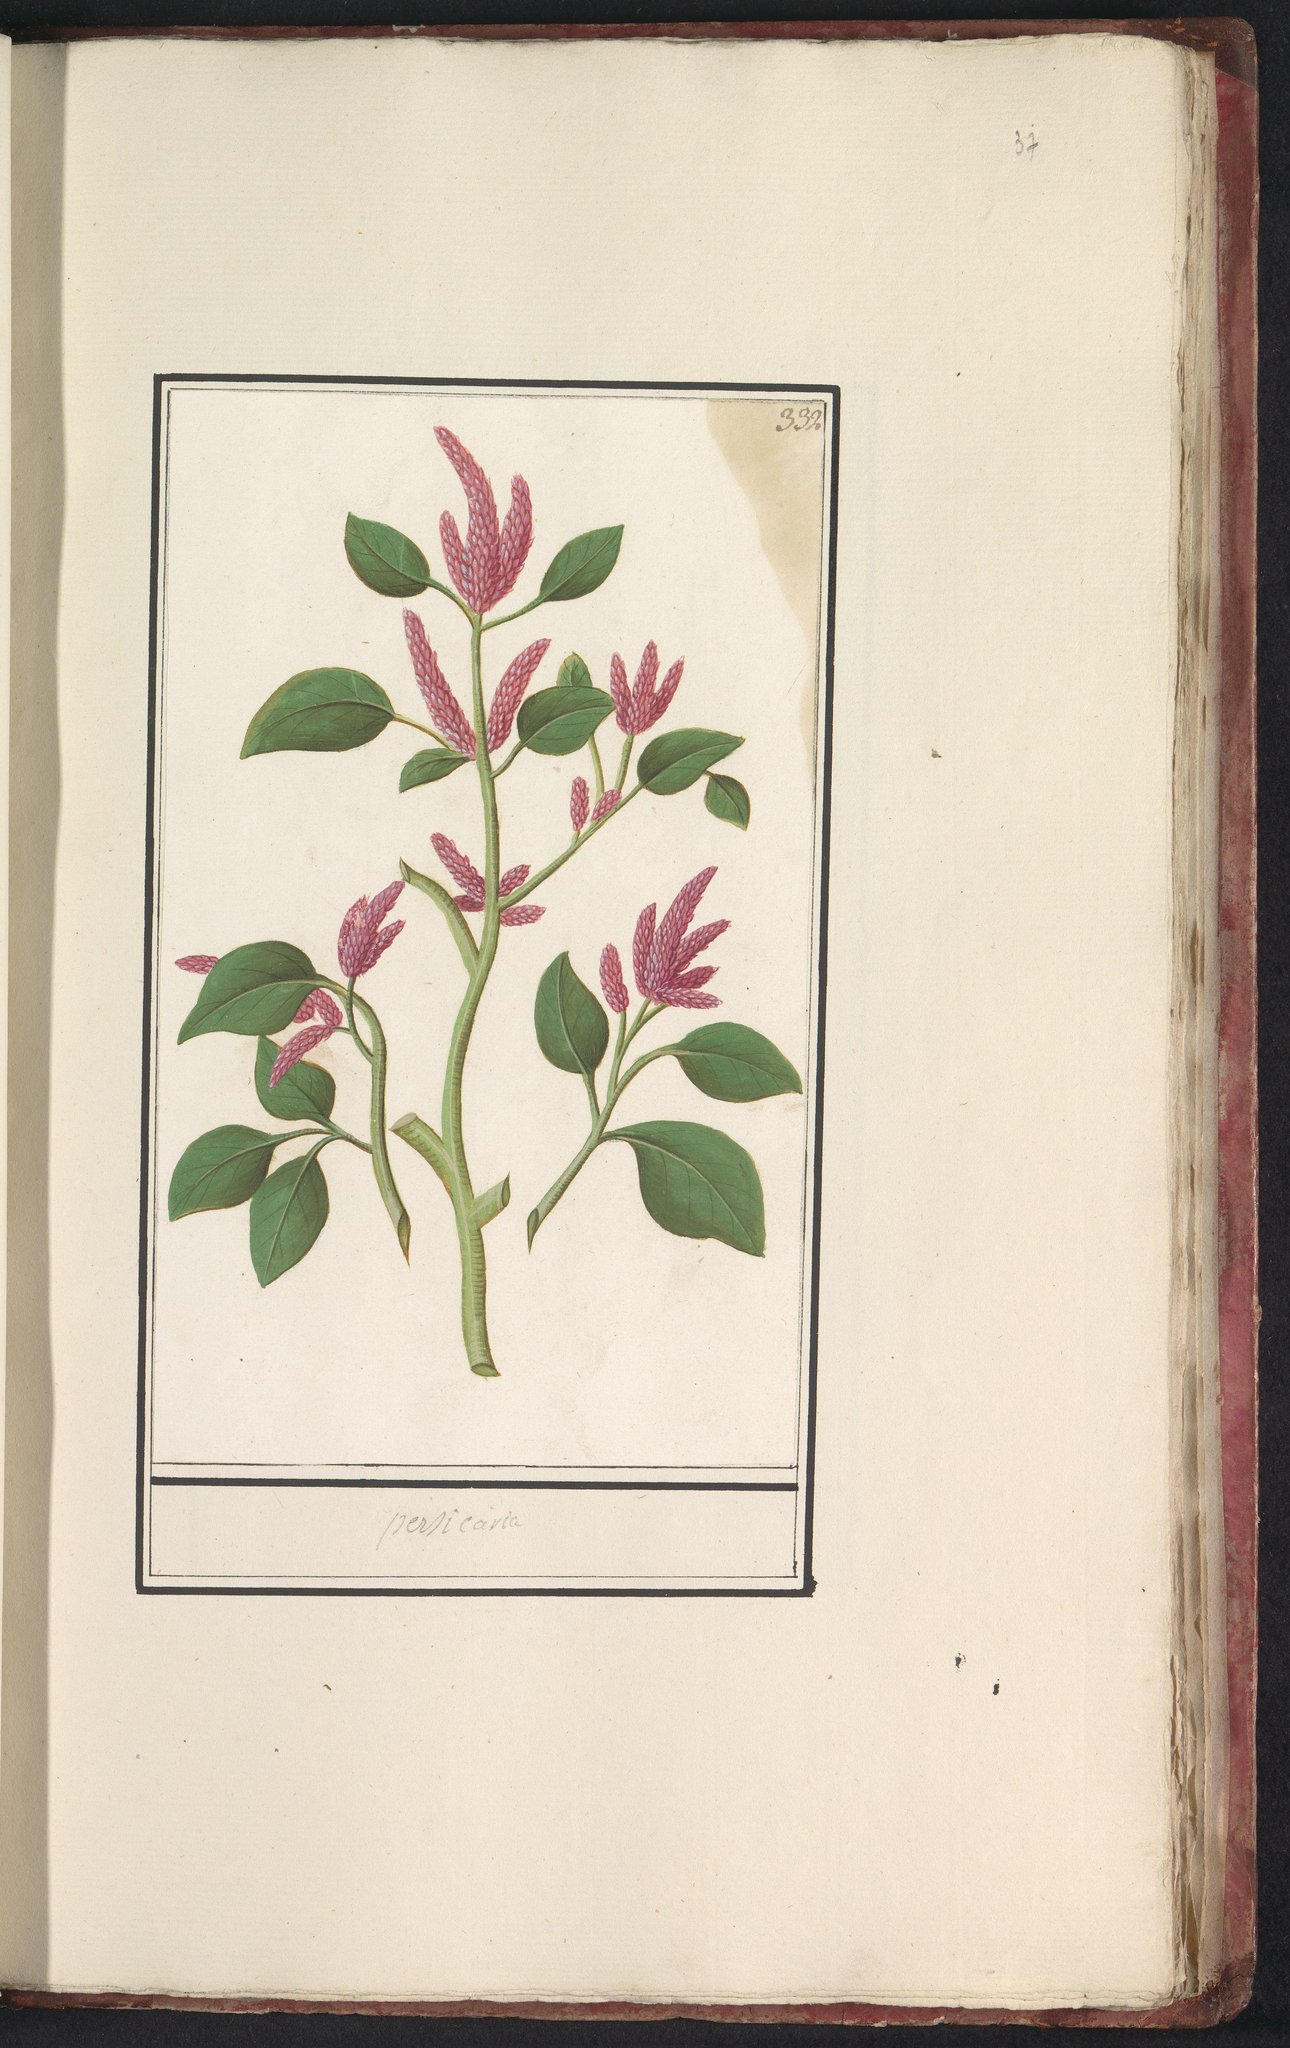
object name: drawing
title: Duizendknoop (Persicaria)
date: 1596-1610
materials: chalk, paint, paper, watercolor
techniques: brush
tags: flowers: knotweed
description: Duizendknoop. Genummerd rechtsboven: 332. Onderdeel van het vierde album met tekeningen van bloemen en paddestoelen. Elfde van twaalf albums met tekeningen van dieren, vogels en planten bekend rond 1600, gemaakt in opdracht van keizer Rudolf II. Met toelichting in Nederlands, Latijn en Frans.